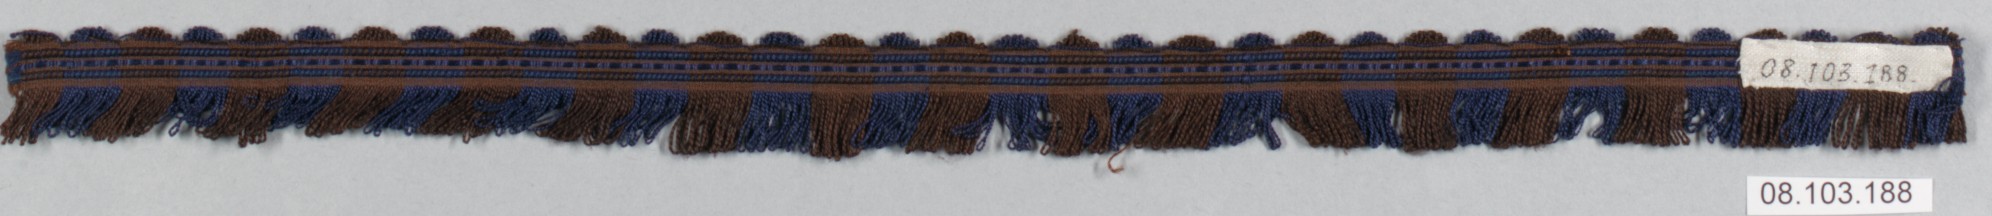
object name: fringe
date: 1801-1900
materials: silk